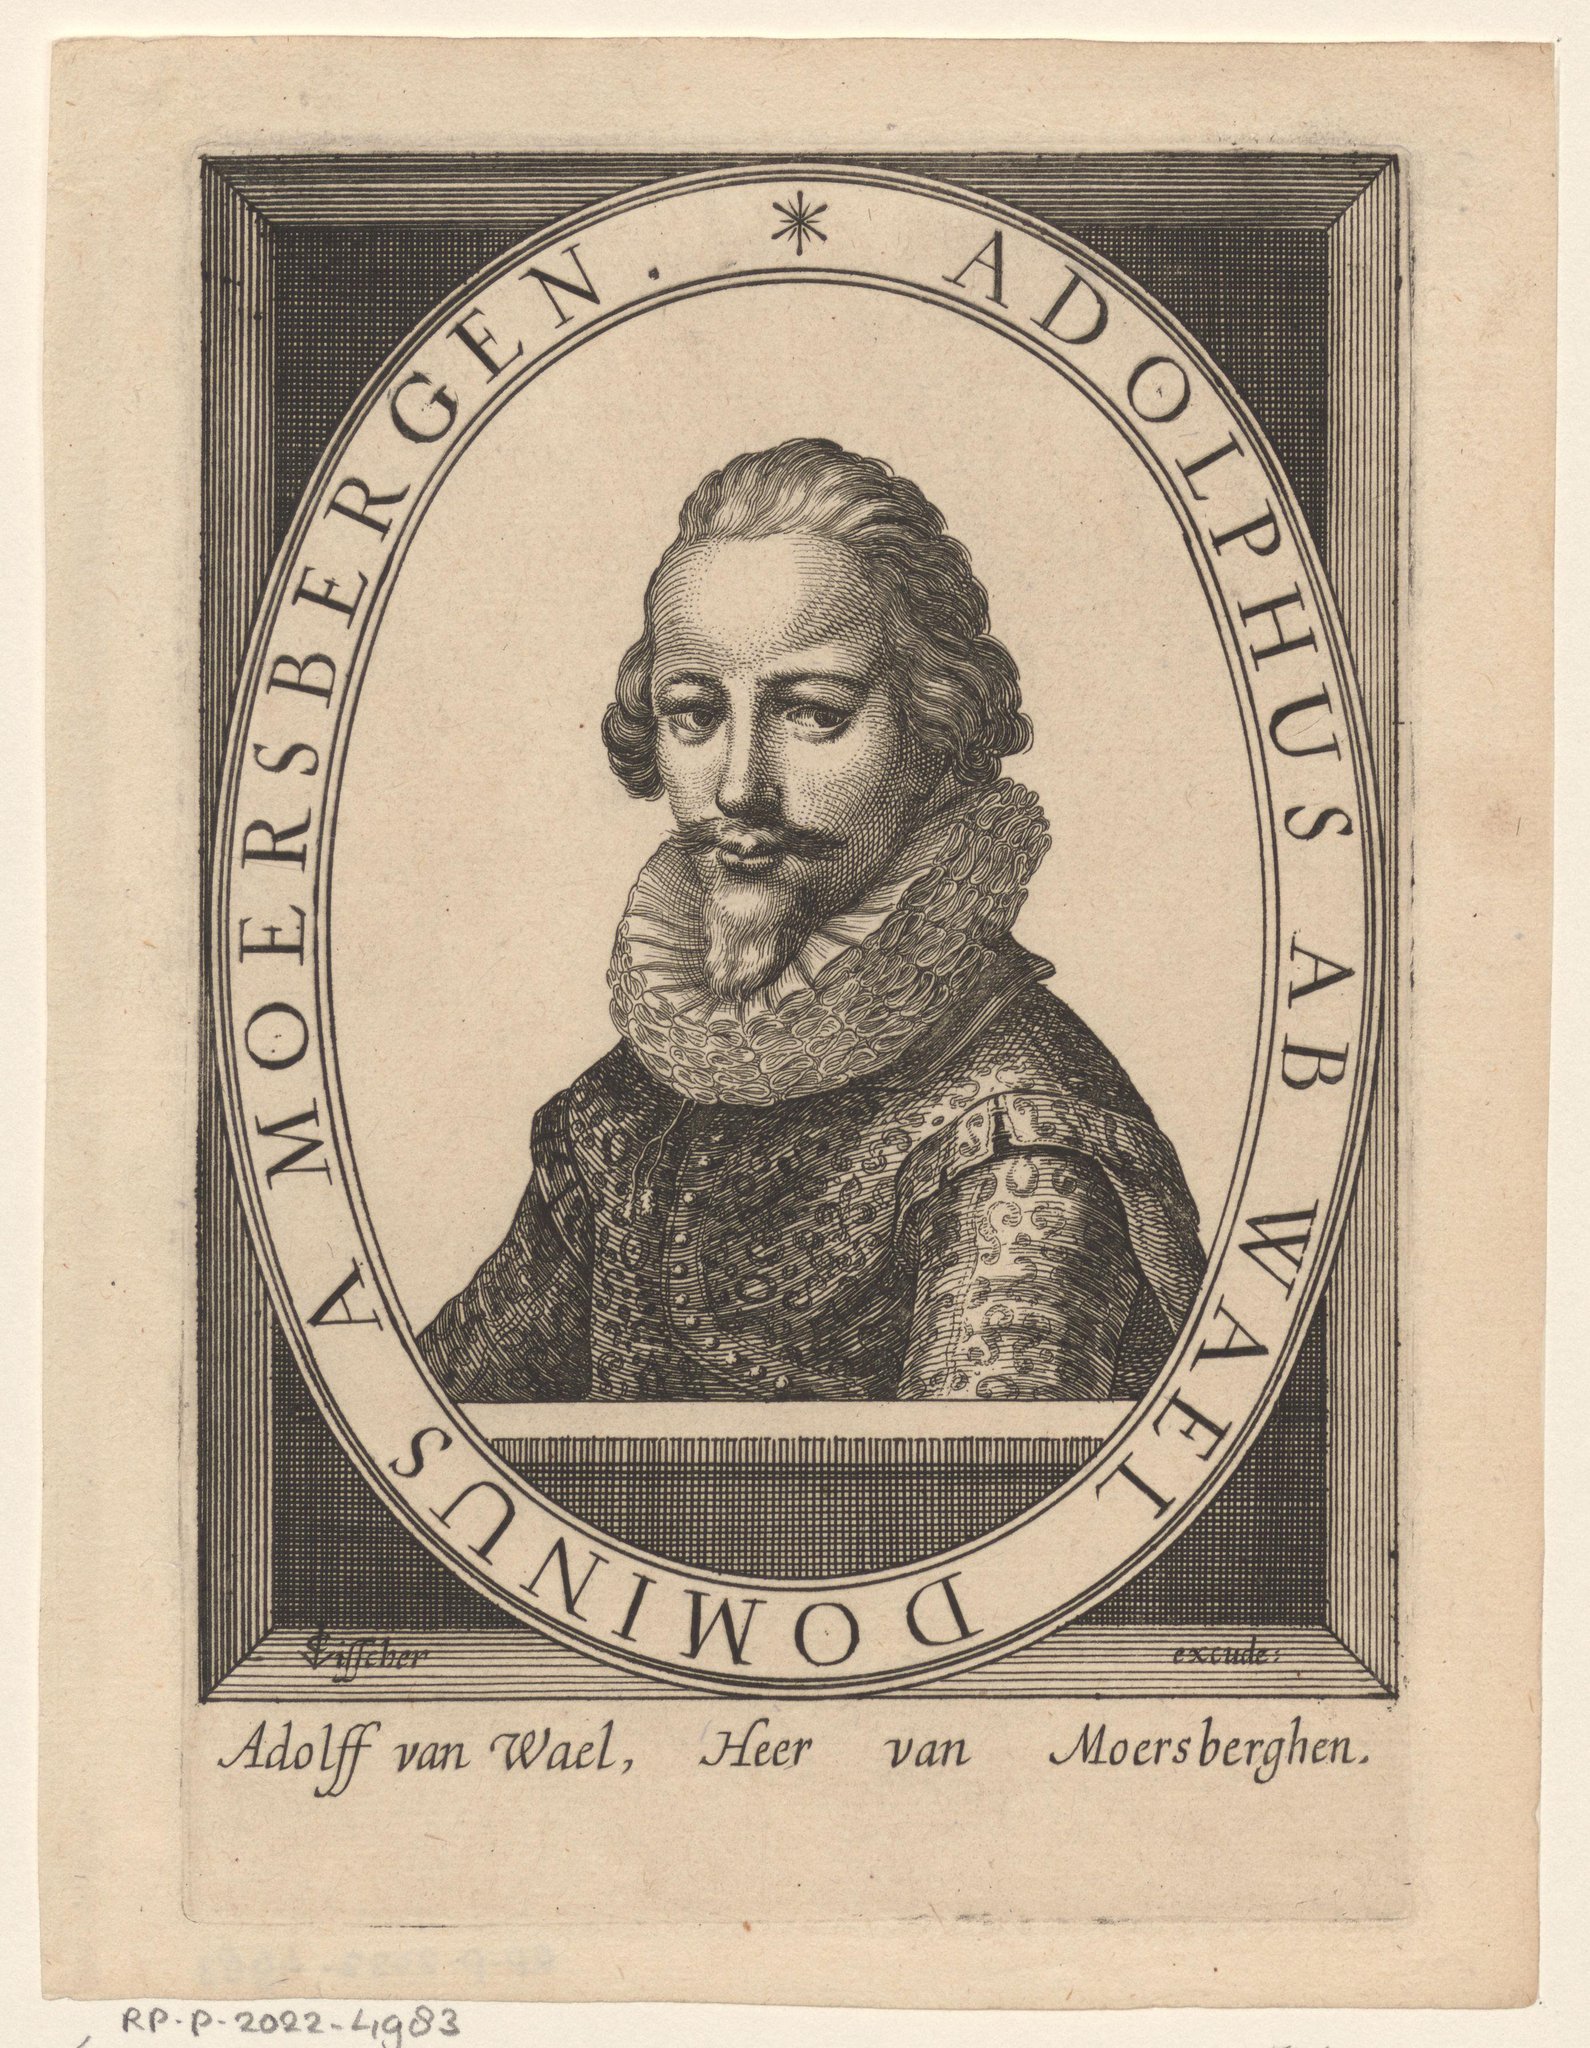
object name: print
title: Portret van Adolf de Wael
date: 1619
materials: paper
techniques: engraving, etching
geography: northern netherlands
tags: historical persons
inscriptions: collector's mark: Lugt 2228